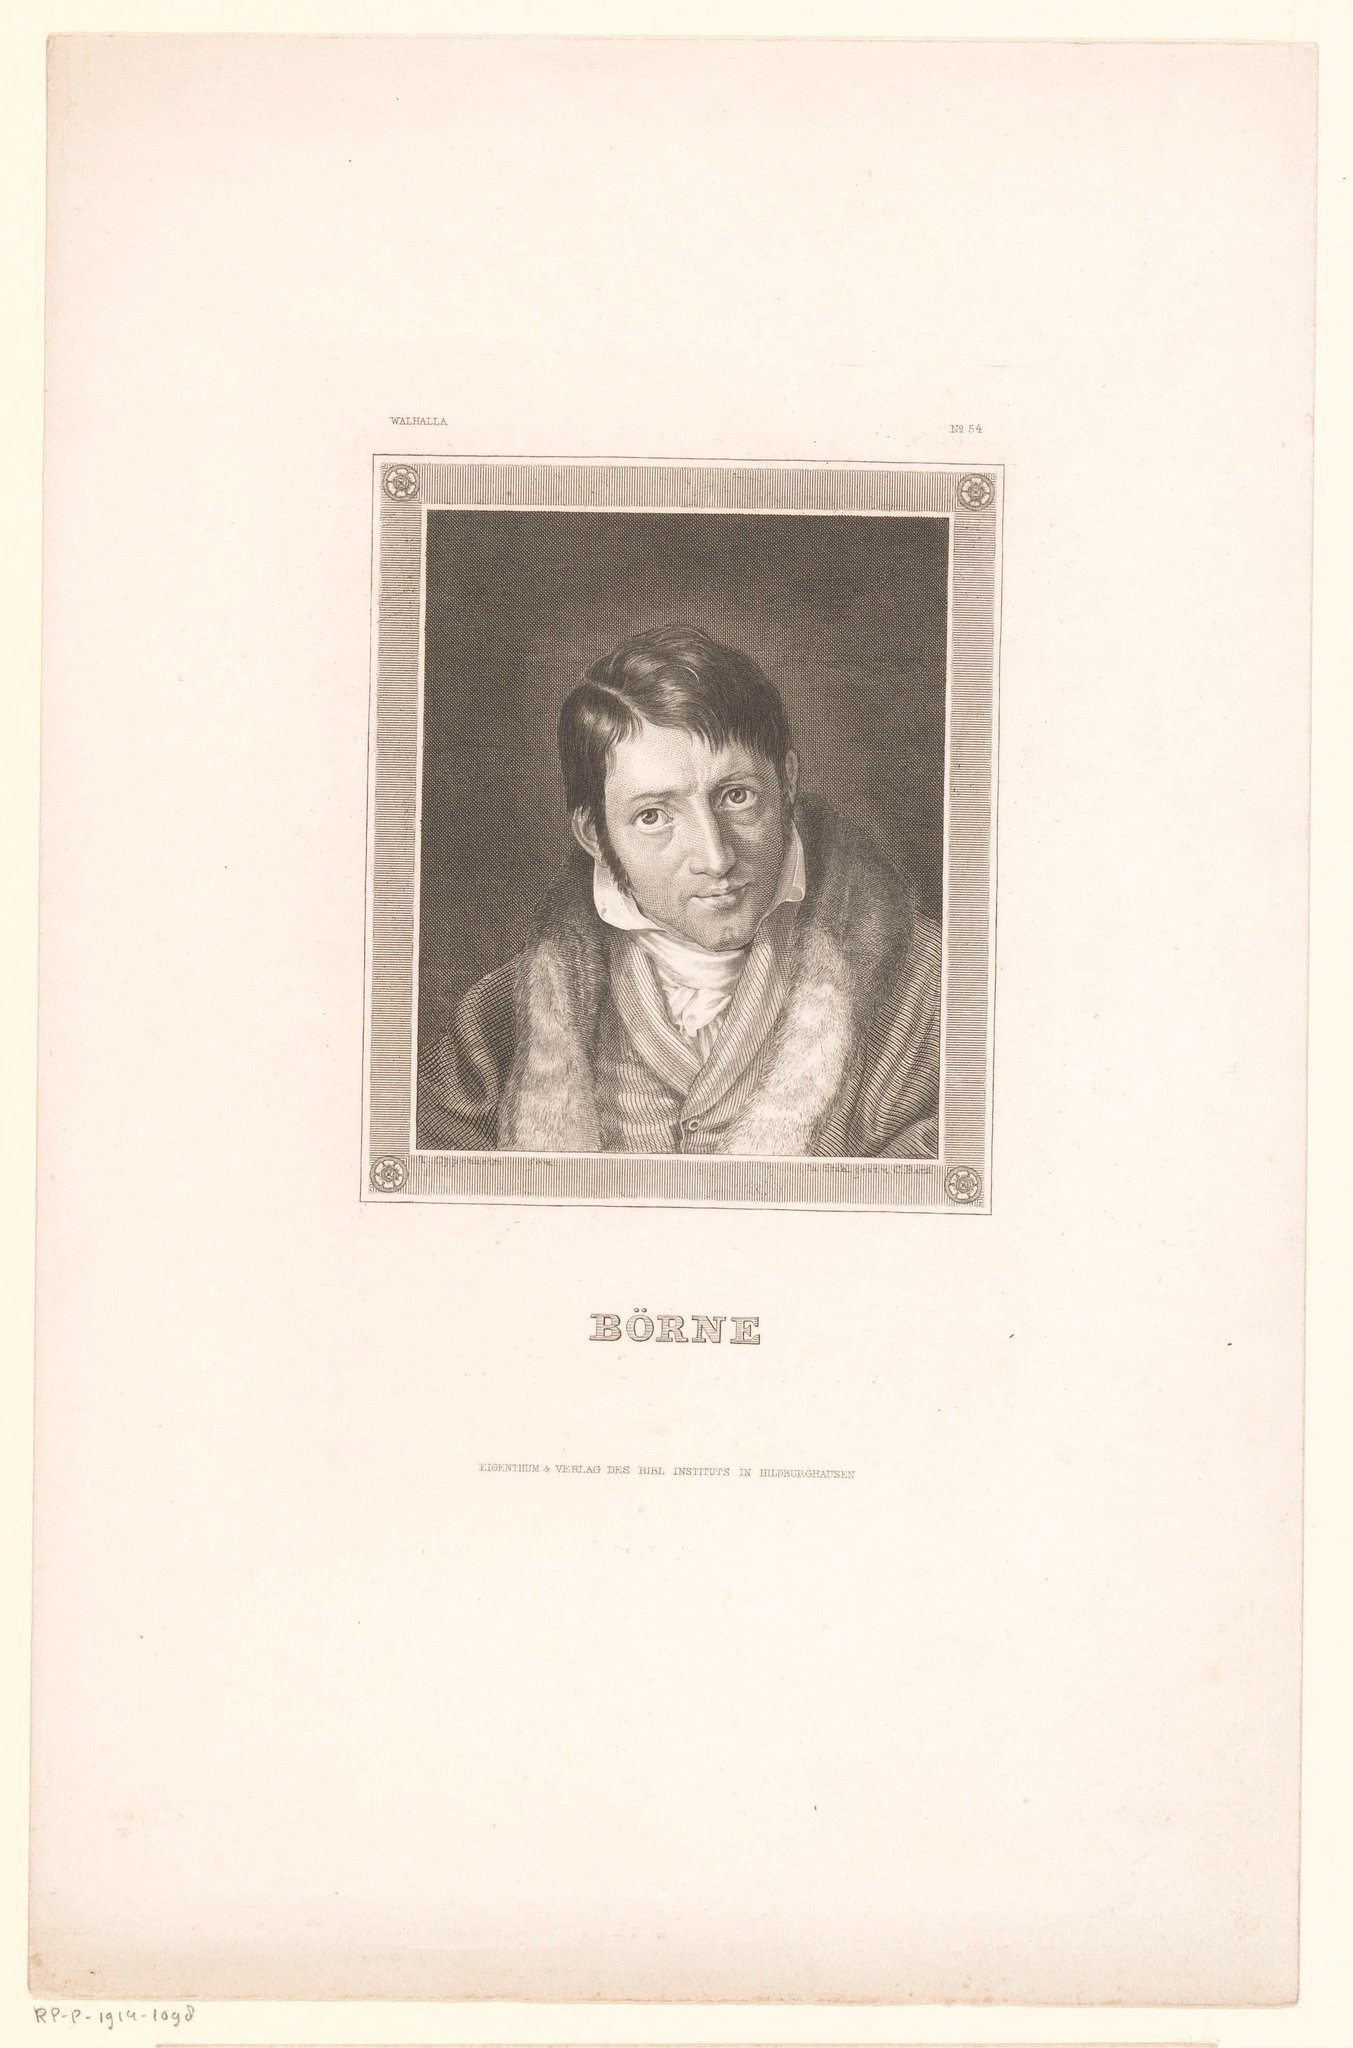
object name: print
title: Walhalla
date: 1852-1856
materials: paper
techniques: engraving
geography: hildburghausen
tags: historical persons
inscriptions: collector's mark: Lugt 2228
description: Afkomstig uit de portretserie 'Walhalla, eine Gallerie der Bildnisse der Zierden des Menschengeschlechts', uitgegeven tussen 1852-1856.